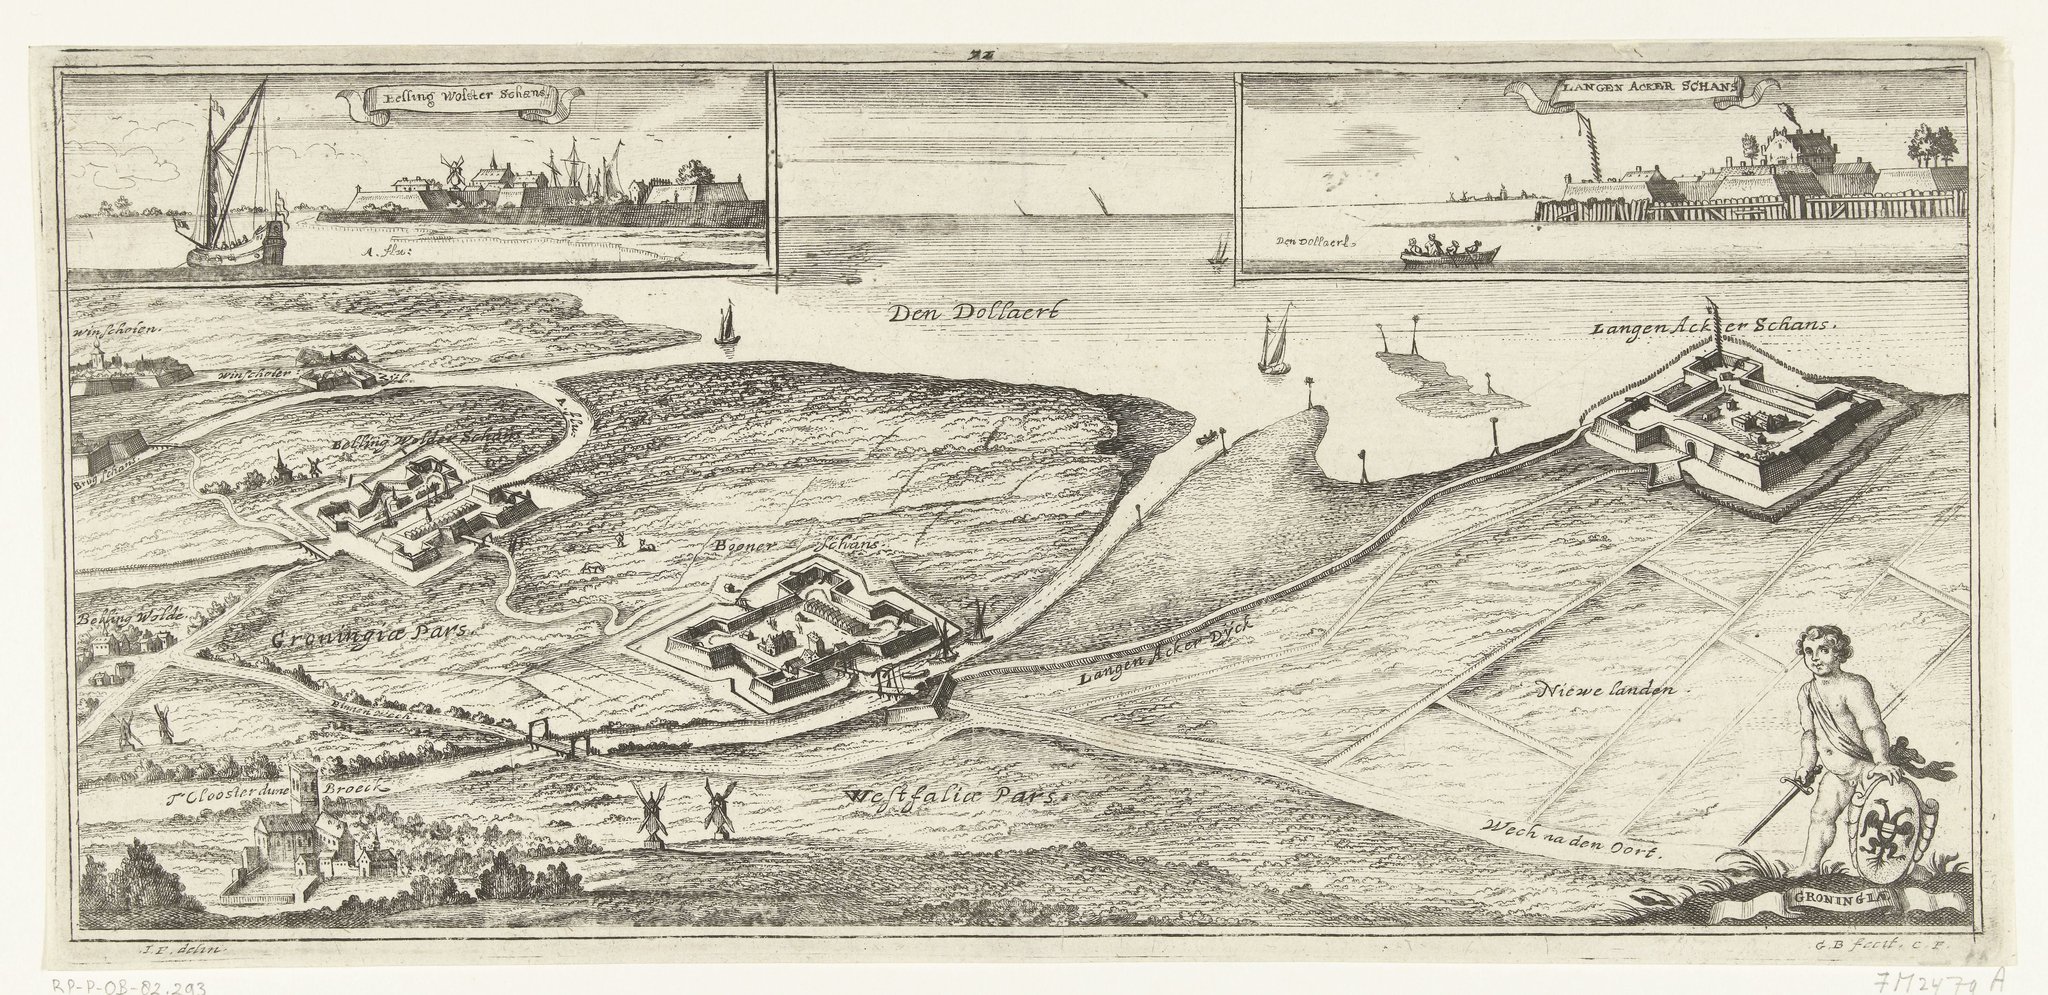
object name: print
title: De schansen in Groningen, 1673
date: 1682-1684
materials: paper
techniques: etching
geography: antwerp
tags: fortress, groningen (province)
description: Uitgegeven in een reeks van (99) stadgezichten: Le Théâtre des Villes et Forteresses des Provinces-Unies et frontières ..., Gaspar Bouttats, Antwerpen 1684.